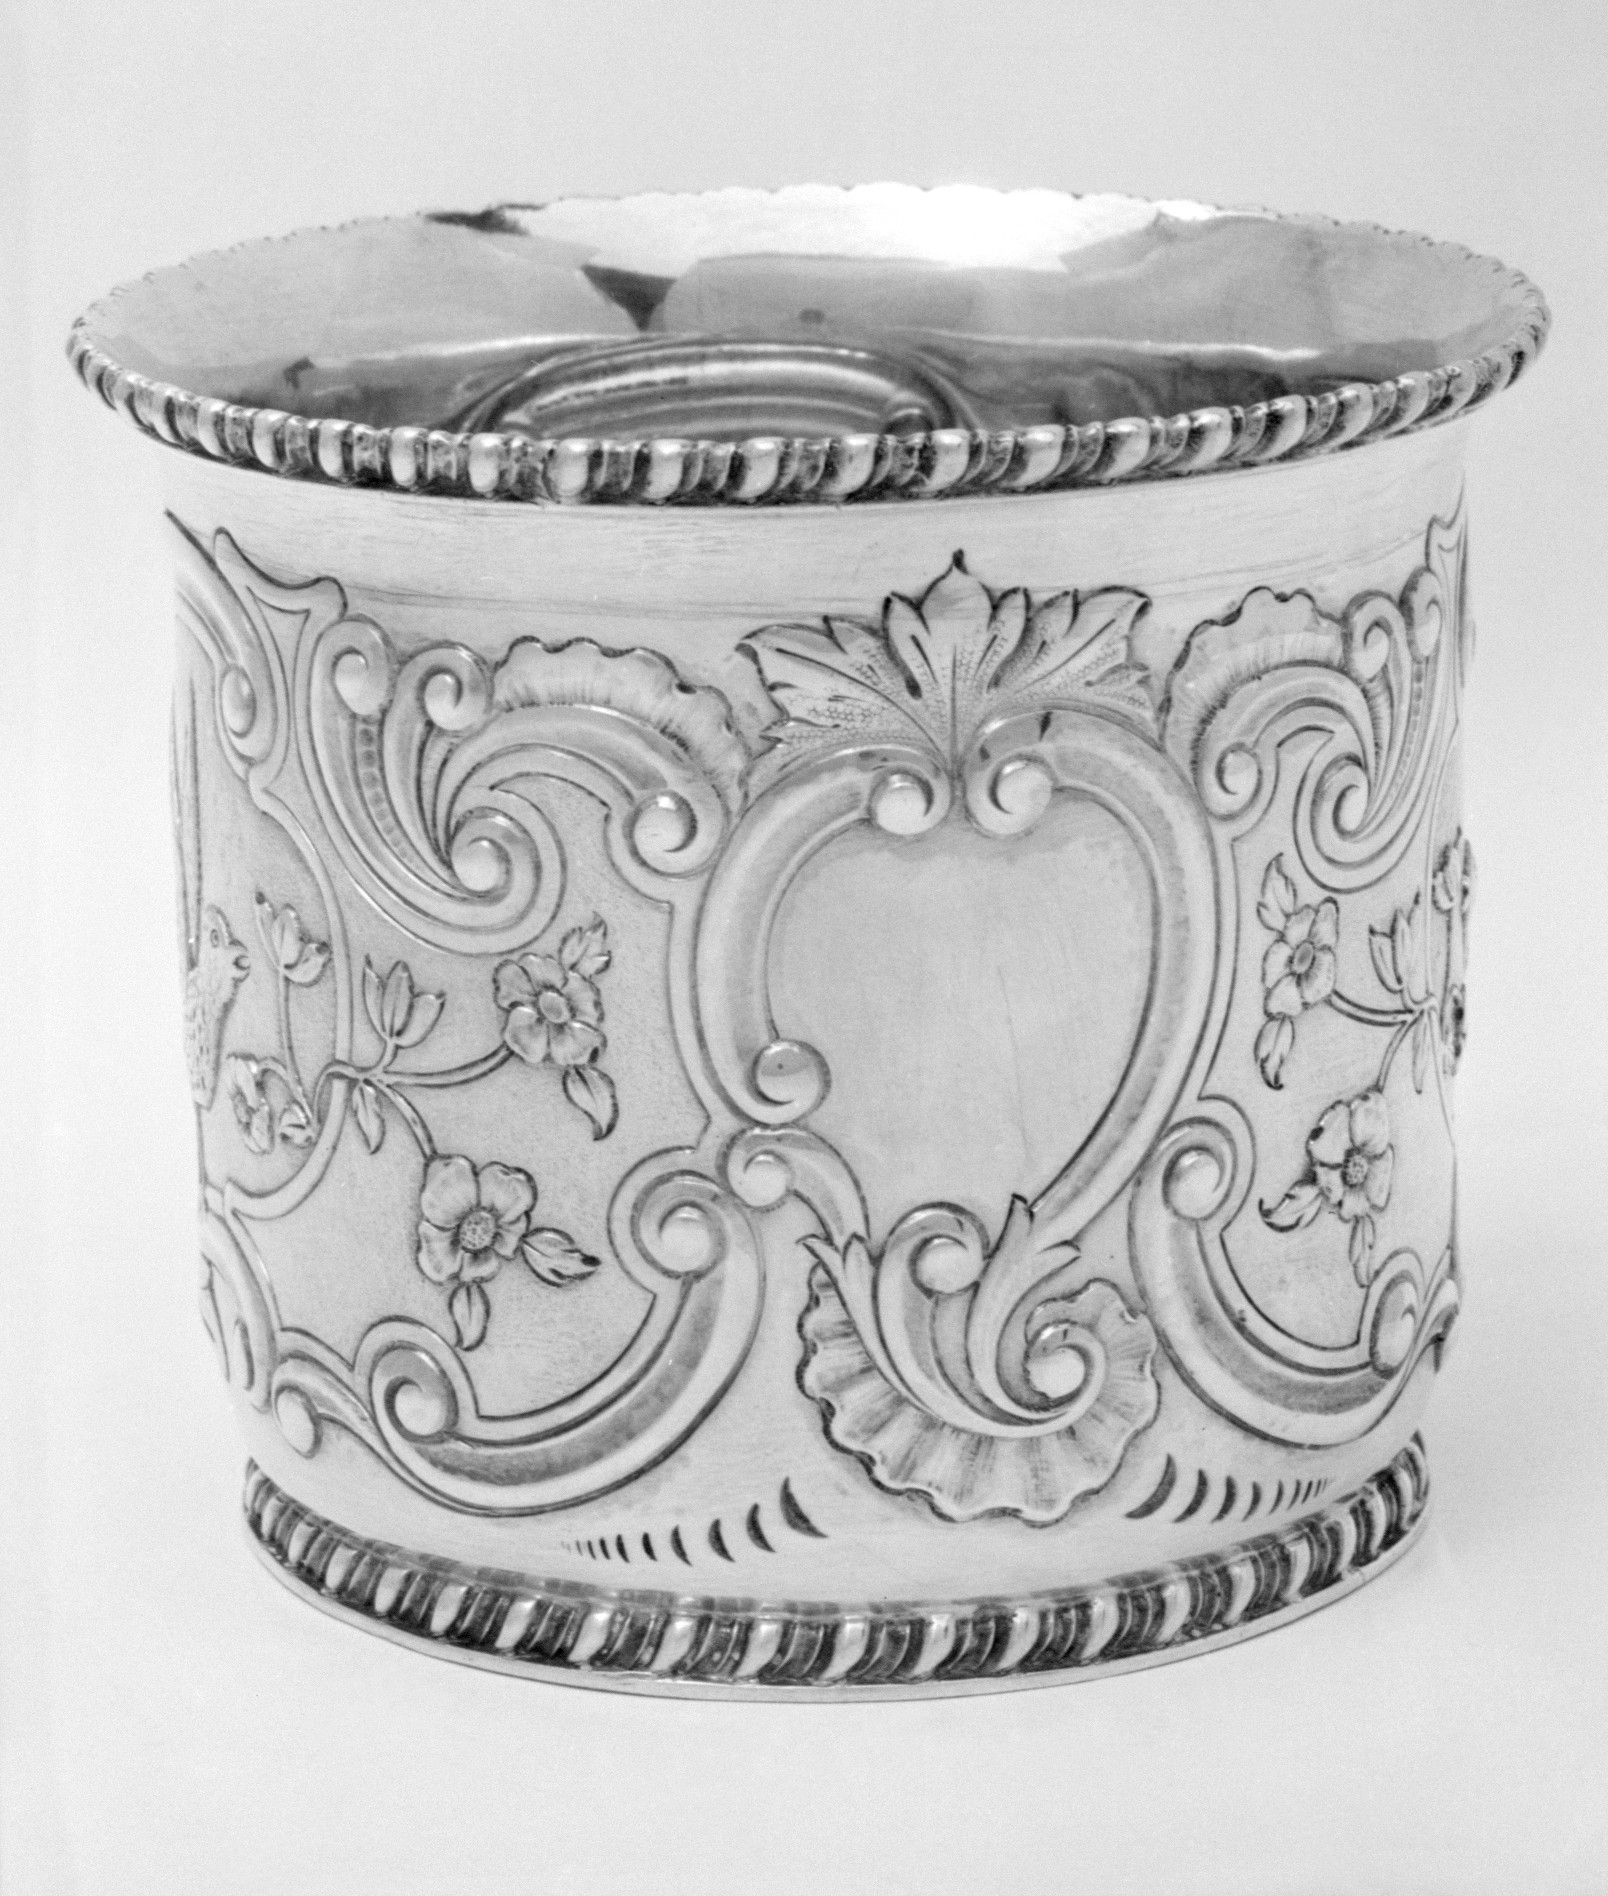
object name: beaker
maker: robert breading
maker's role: maker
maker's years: 1775-1822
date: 1806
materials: silver